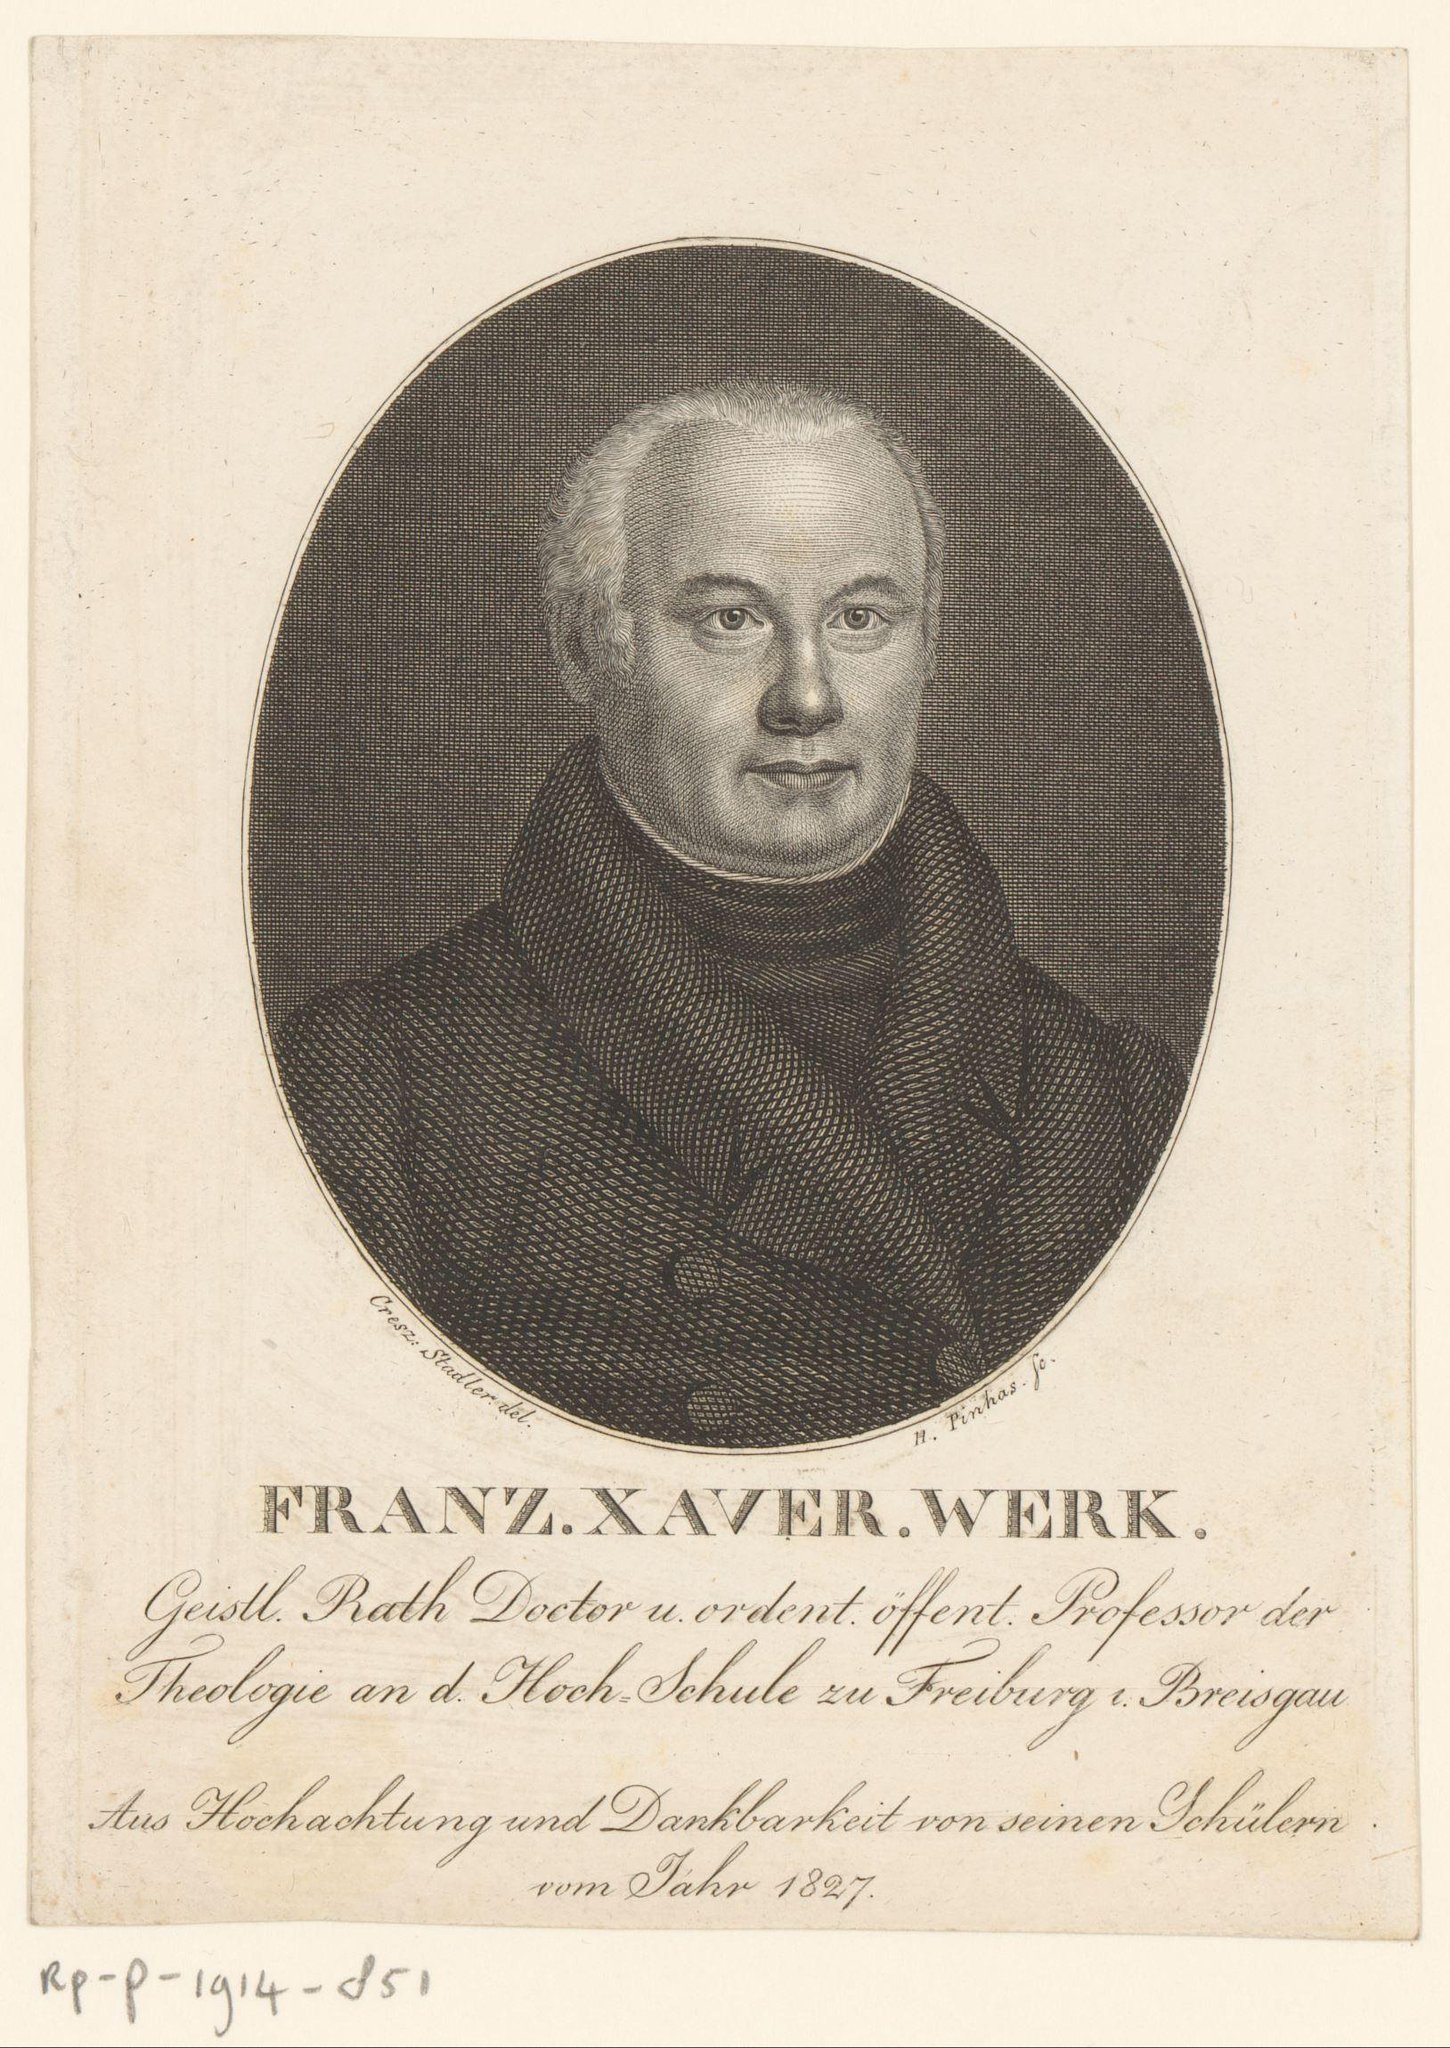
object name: print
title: Portret van Franz Xaver Werk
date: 1827-1844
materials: paper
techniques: engraving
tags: historical persons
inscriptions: collector's mark: Lugt 2228